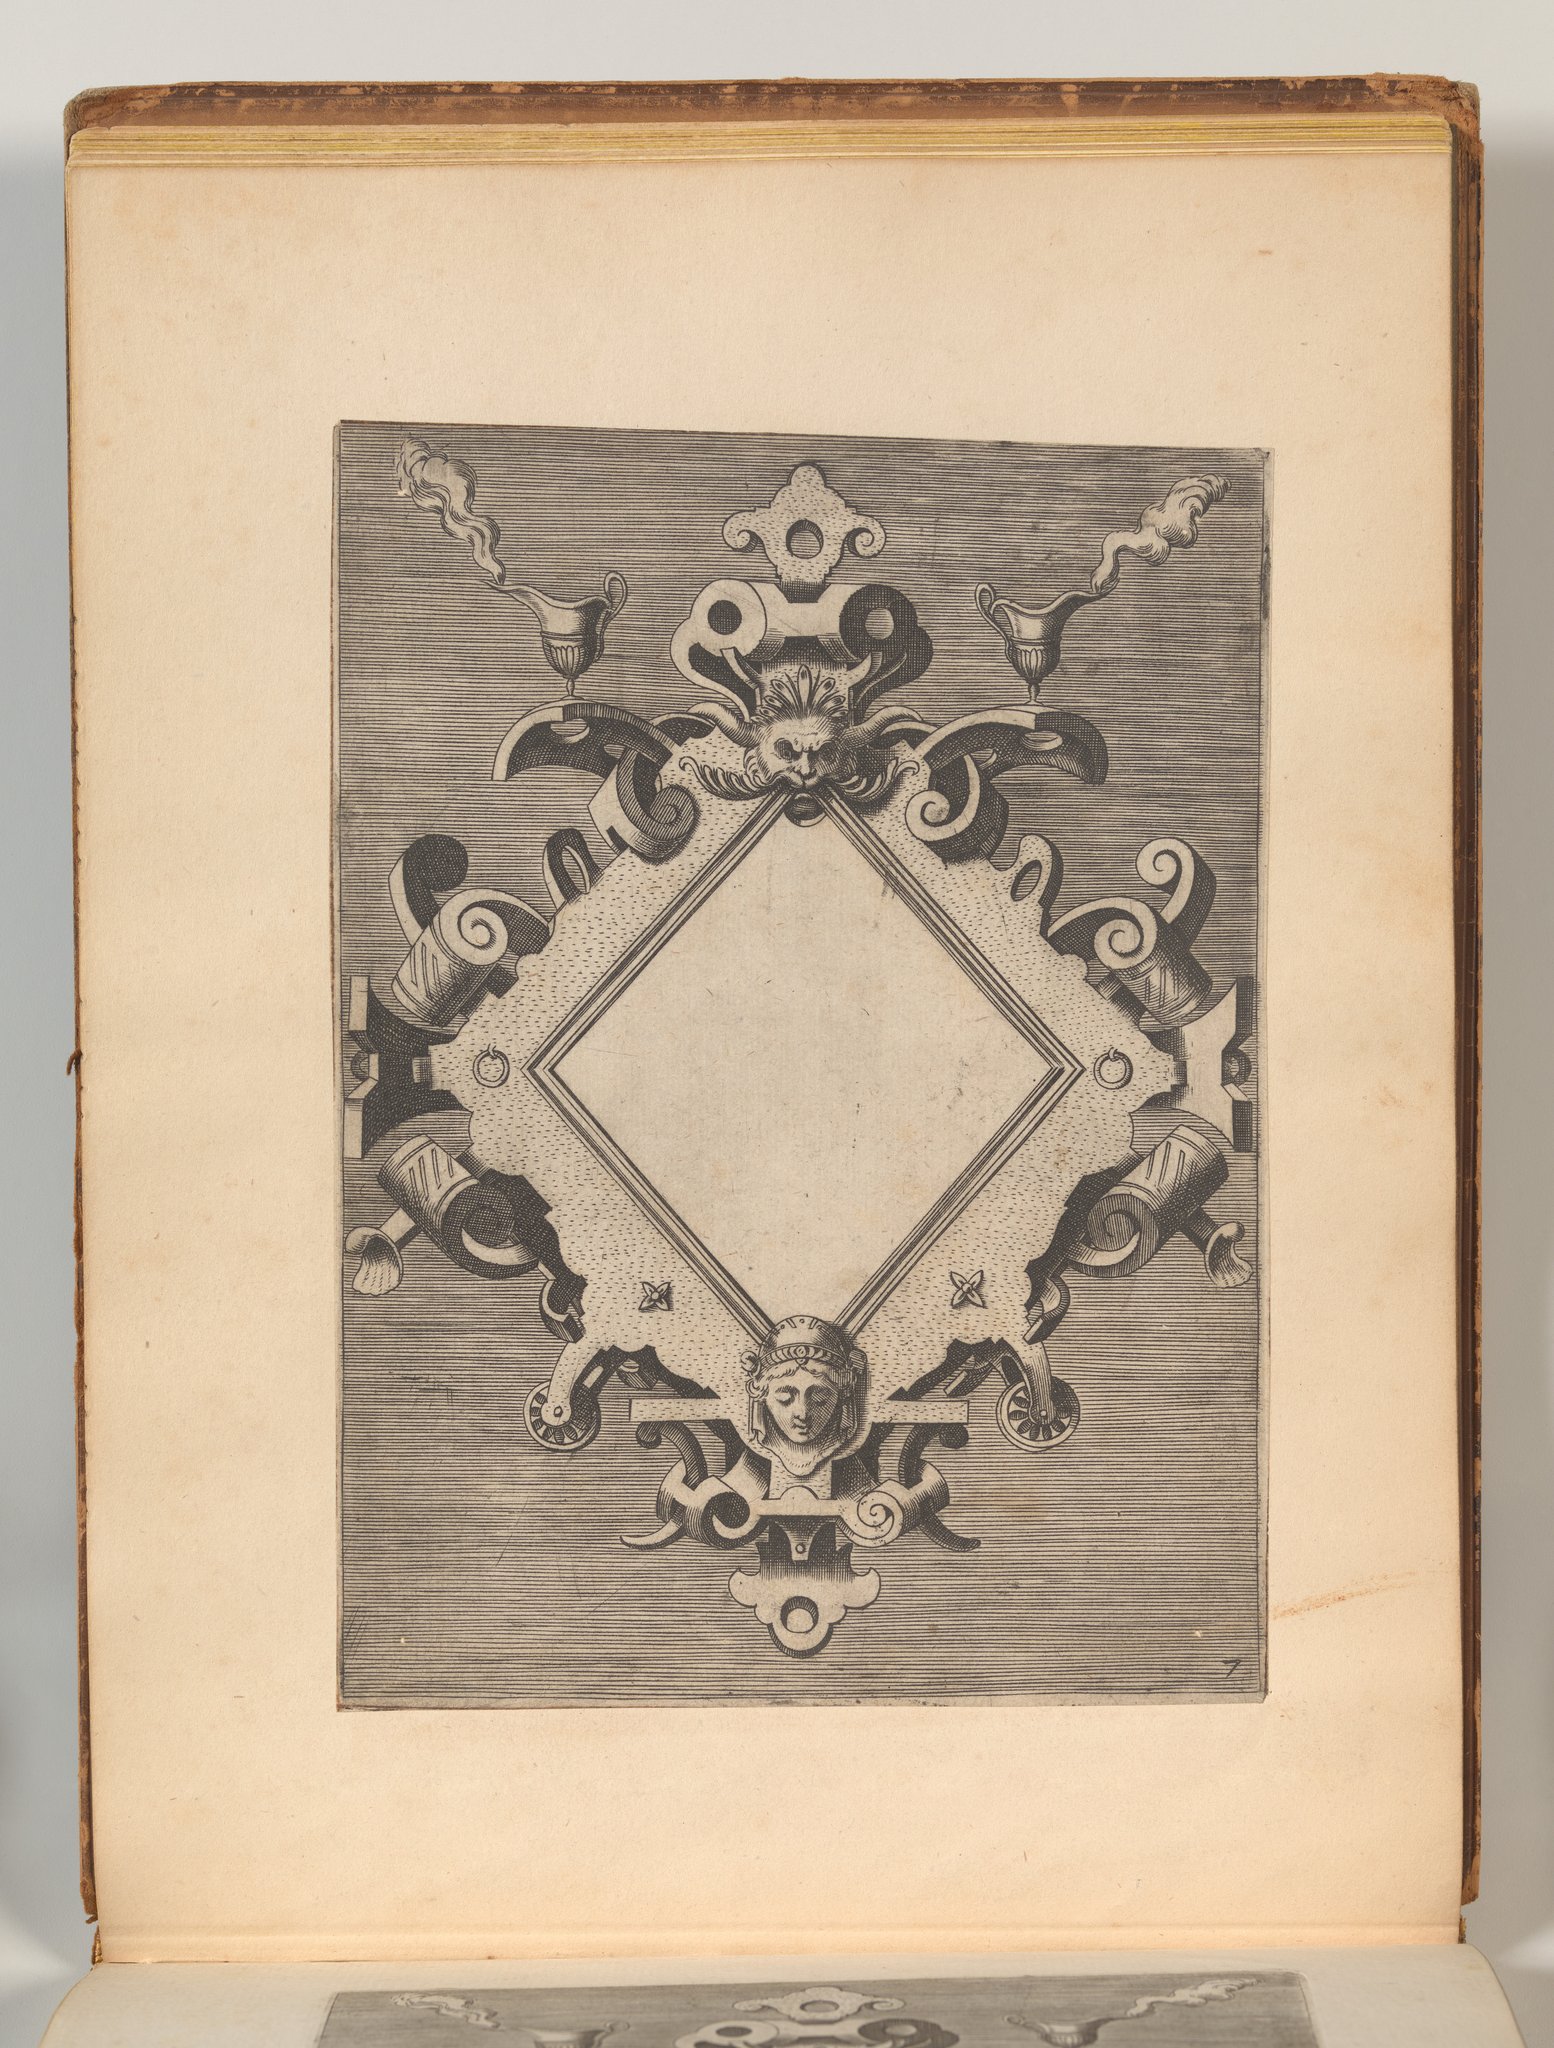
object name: album print ornament architecture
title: Targhe ed altri ornati di varie e capricciose invenzioni (Cartouches and other ornaments of various and capricious invention, page 23)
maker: hans vredeman de vries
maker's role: artist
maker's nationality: netherlandish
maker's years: 1527-1606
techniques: engraving, etching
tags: ornament